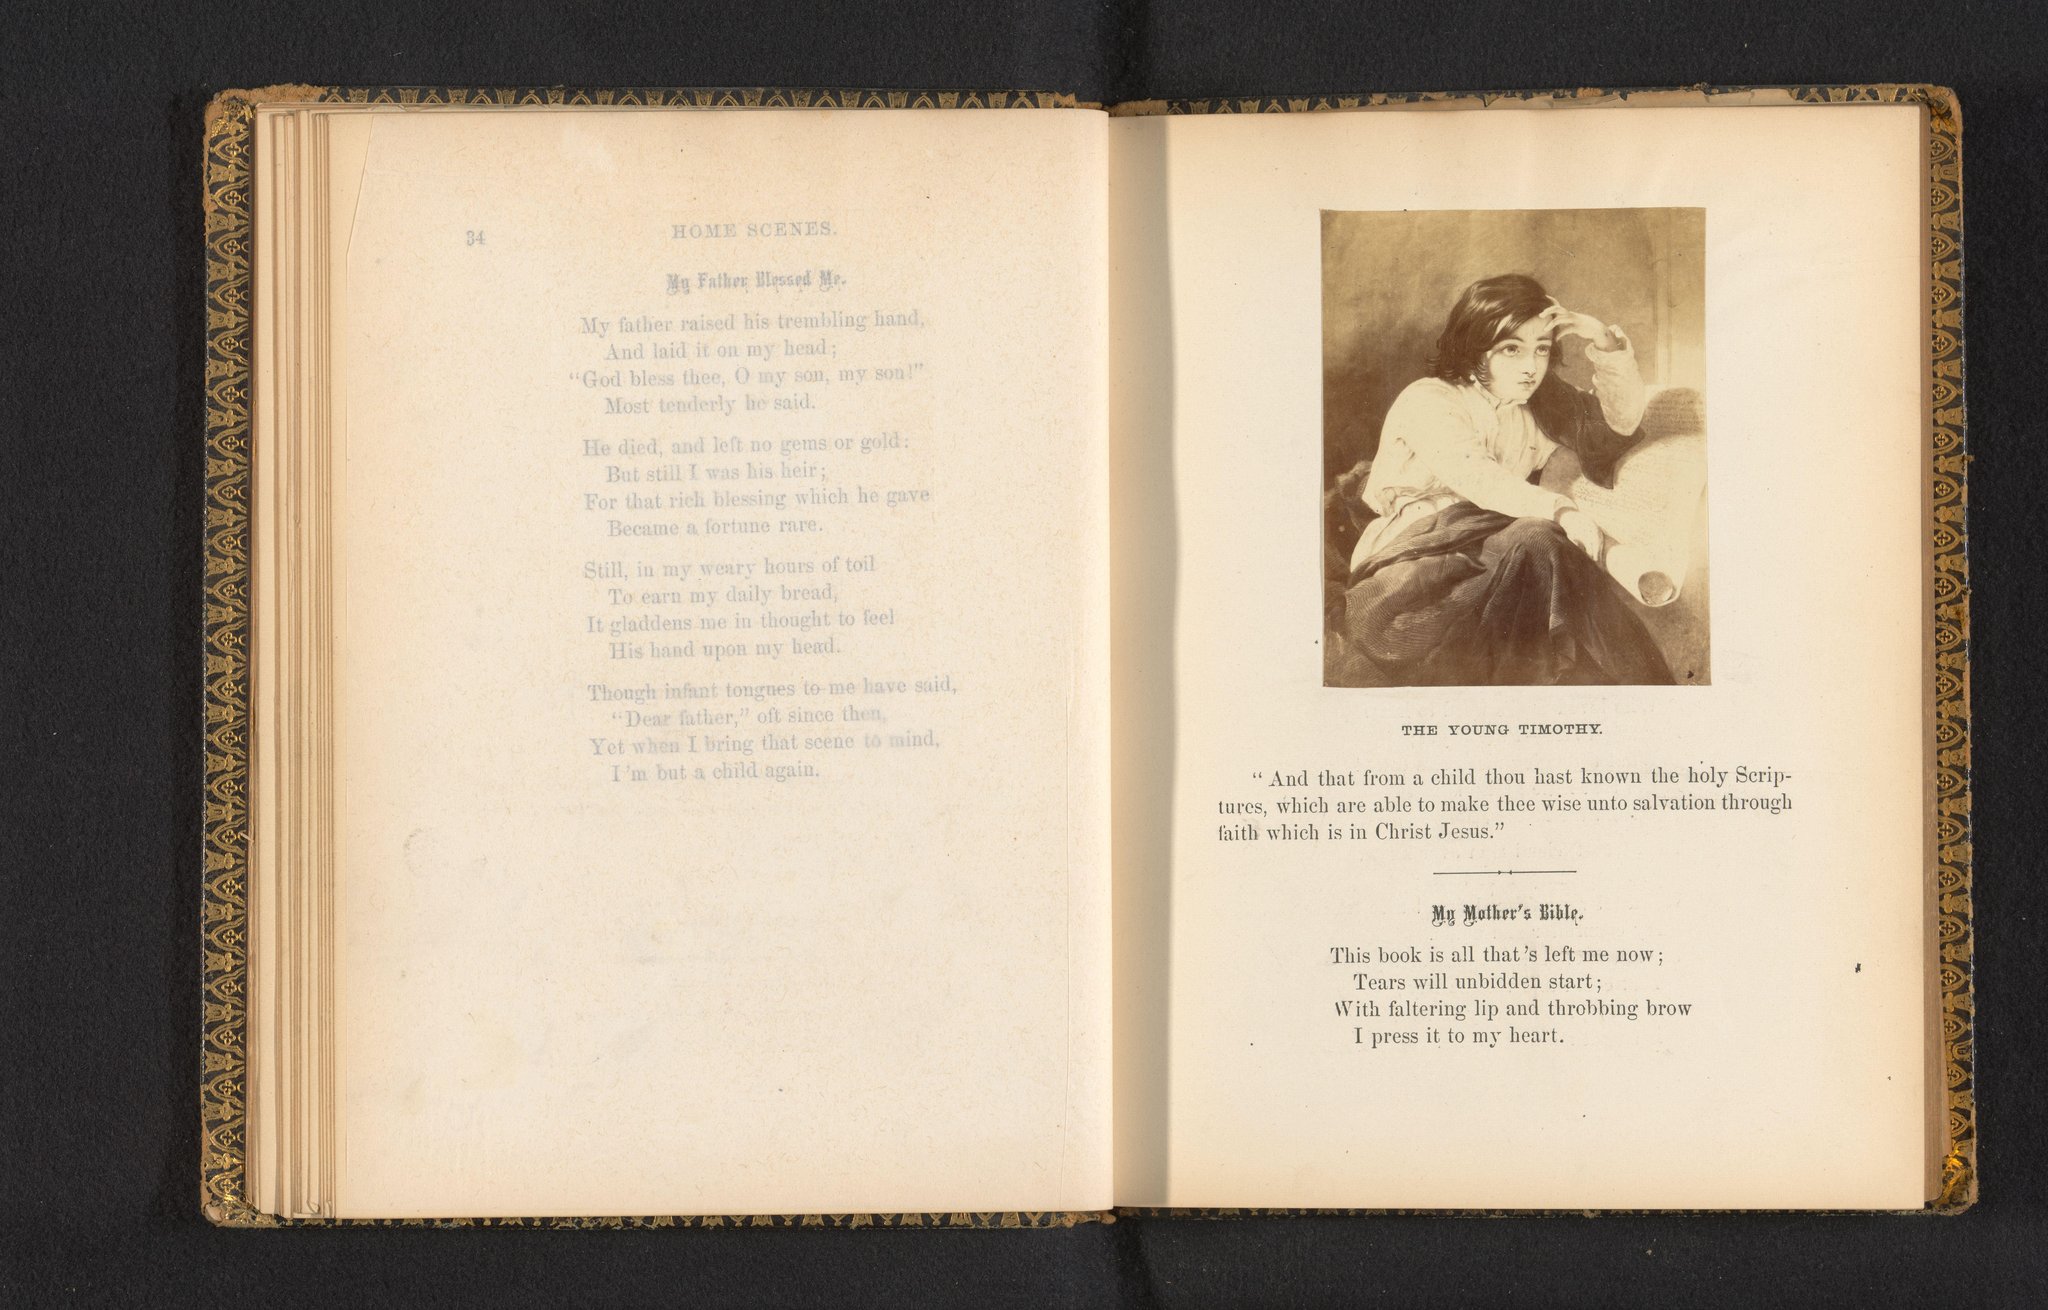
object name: photograph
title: The young Timothy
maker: Anonymous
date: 1860-1865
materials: photographic support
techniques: albumen print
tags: child, letter, envelope